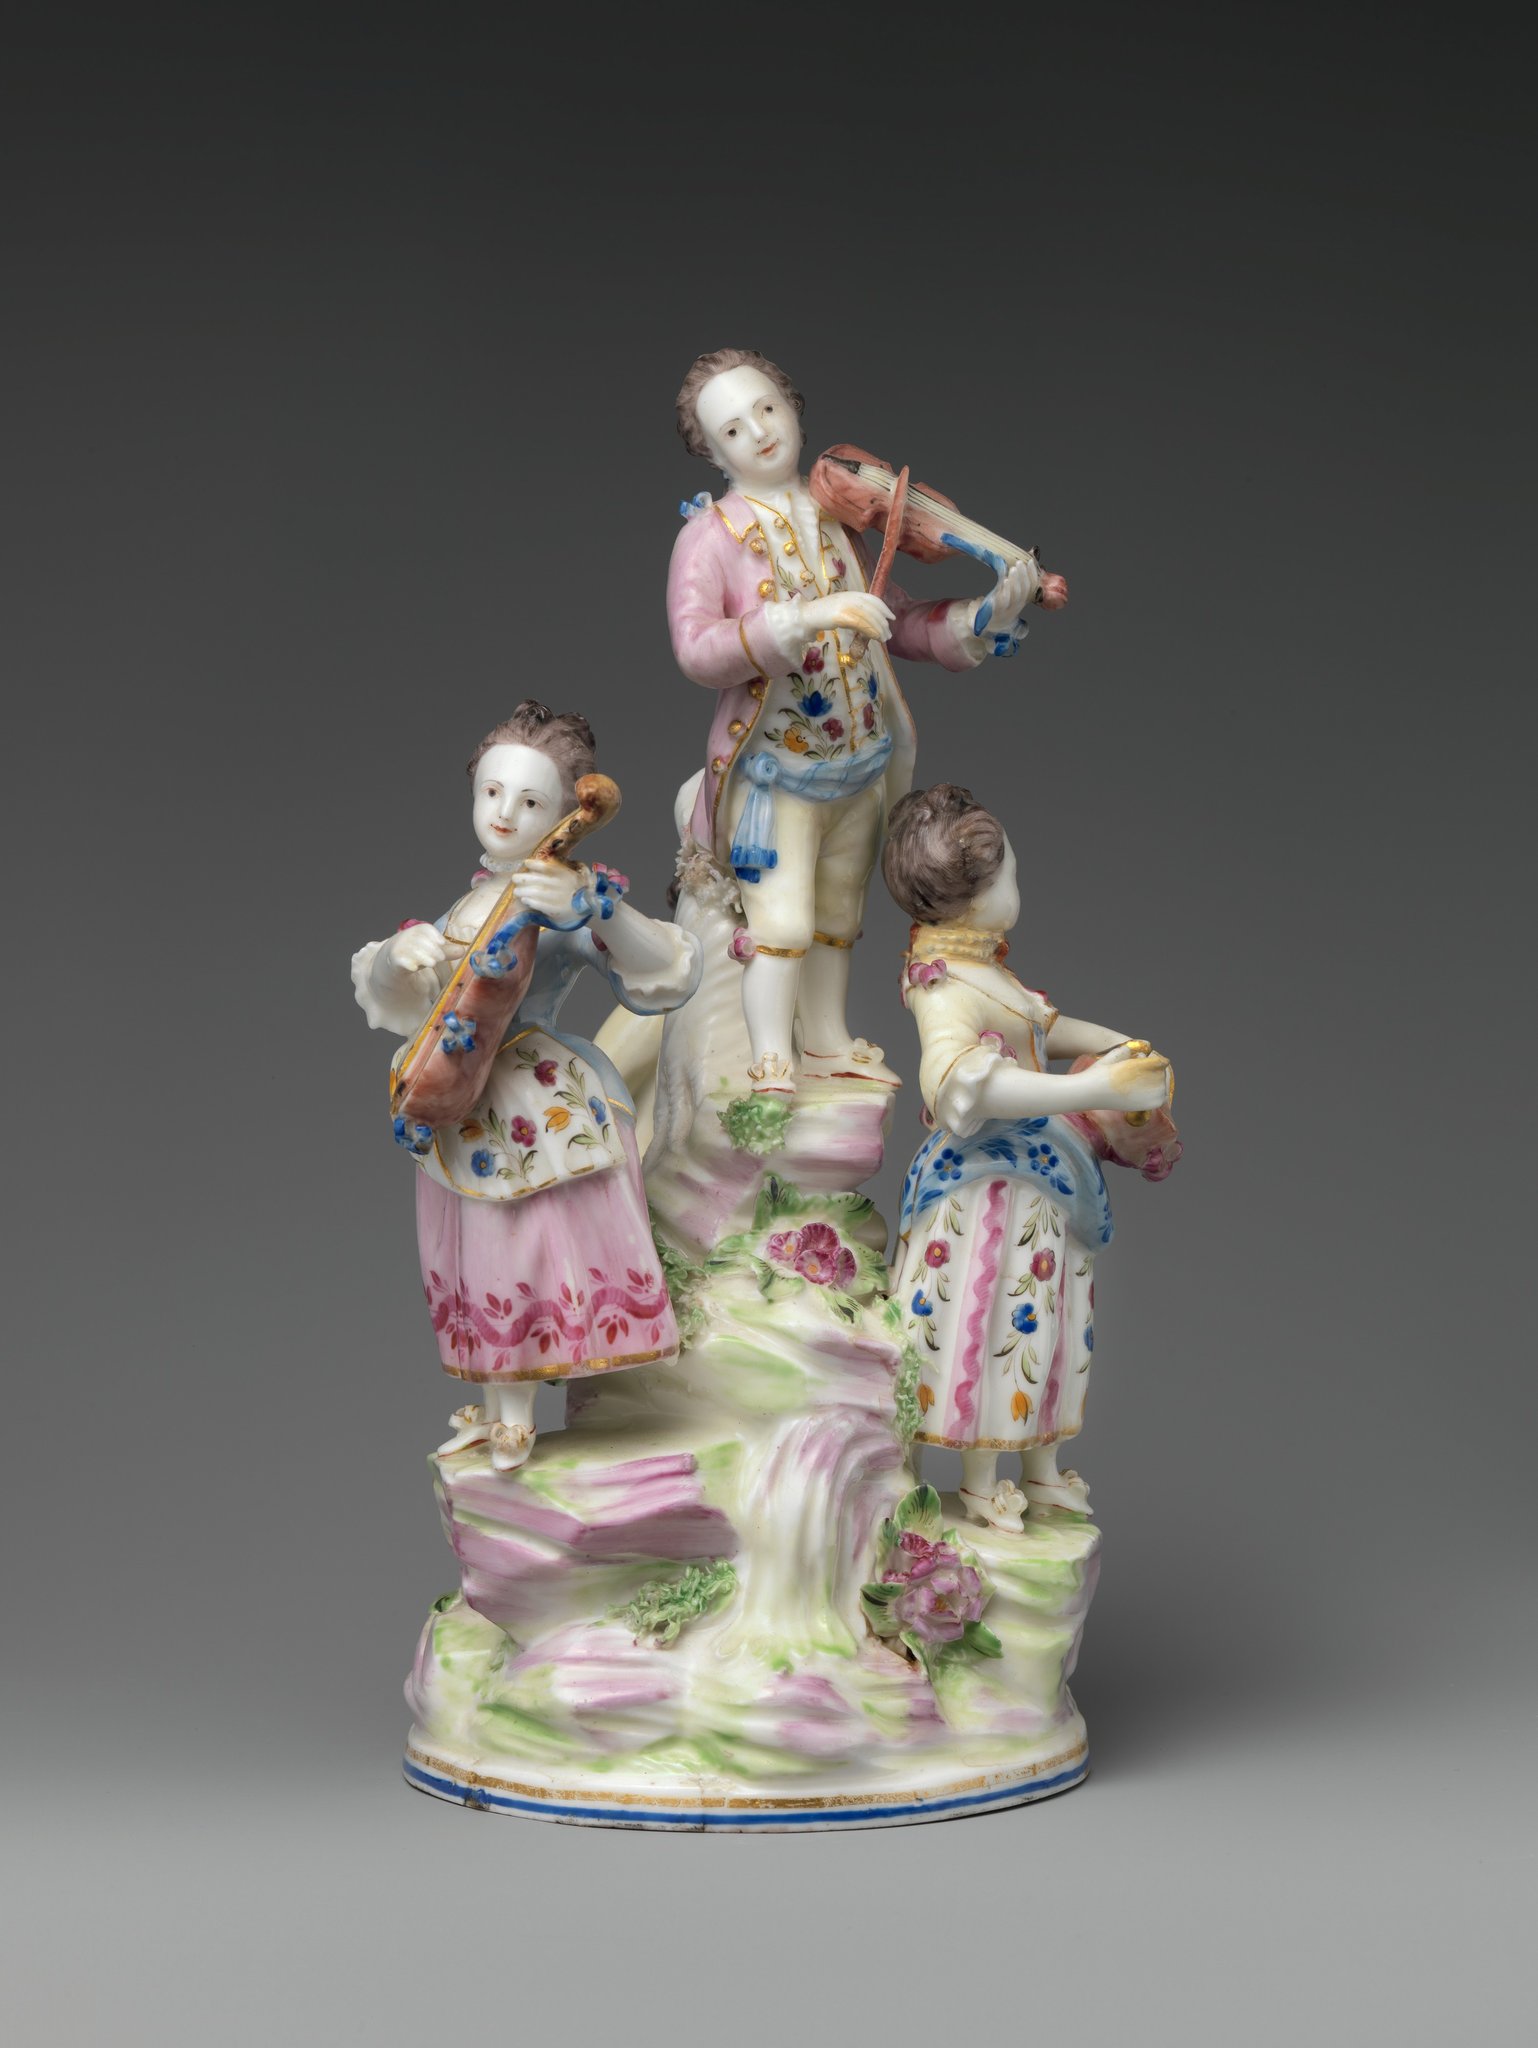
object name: group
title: Four musicians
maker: mennecy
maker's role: factory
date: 1765-1770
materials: soft paste porcelain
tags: men,women,violins,musicians